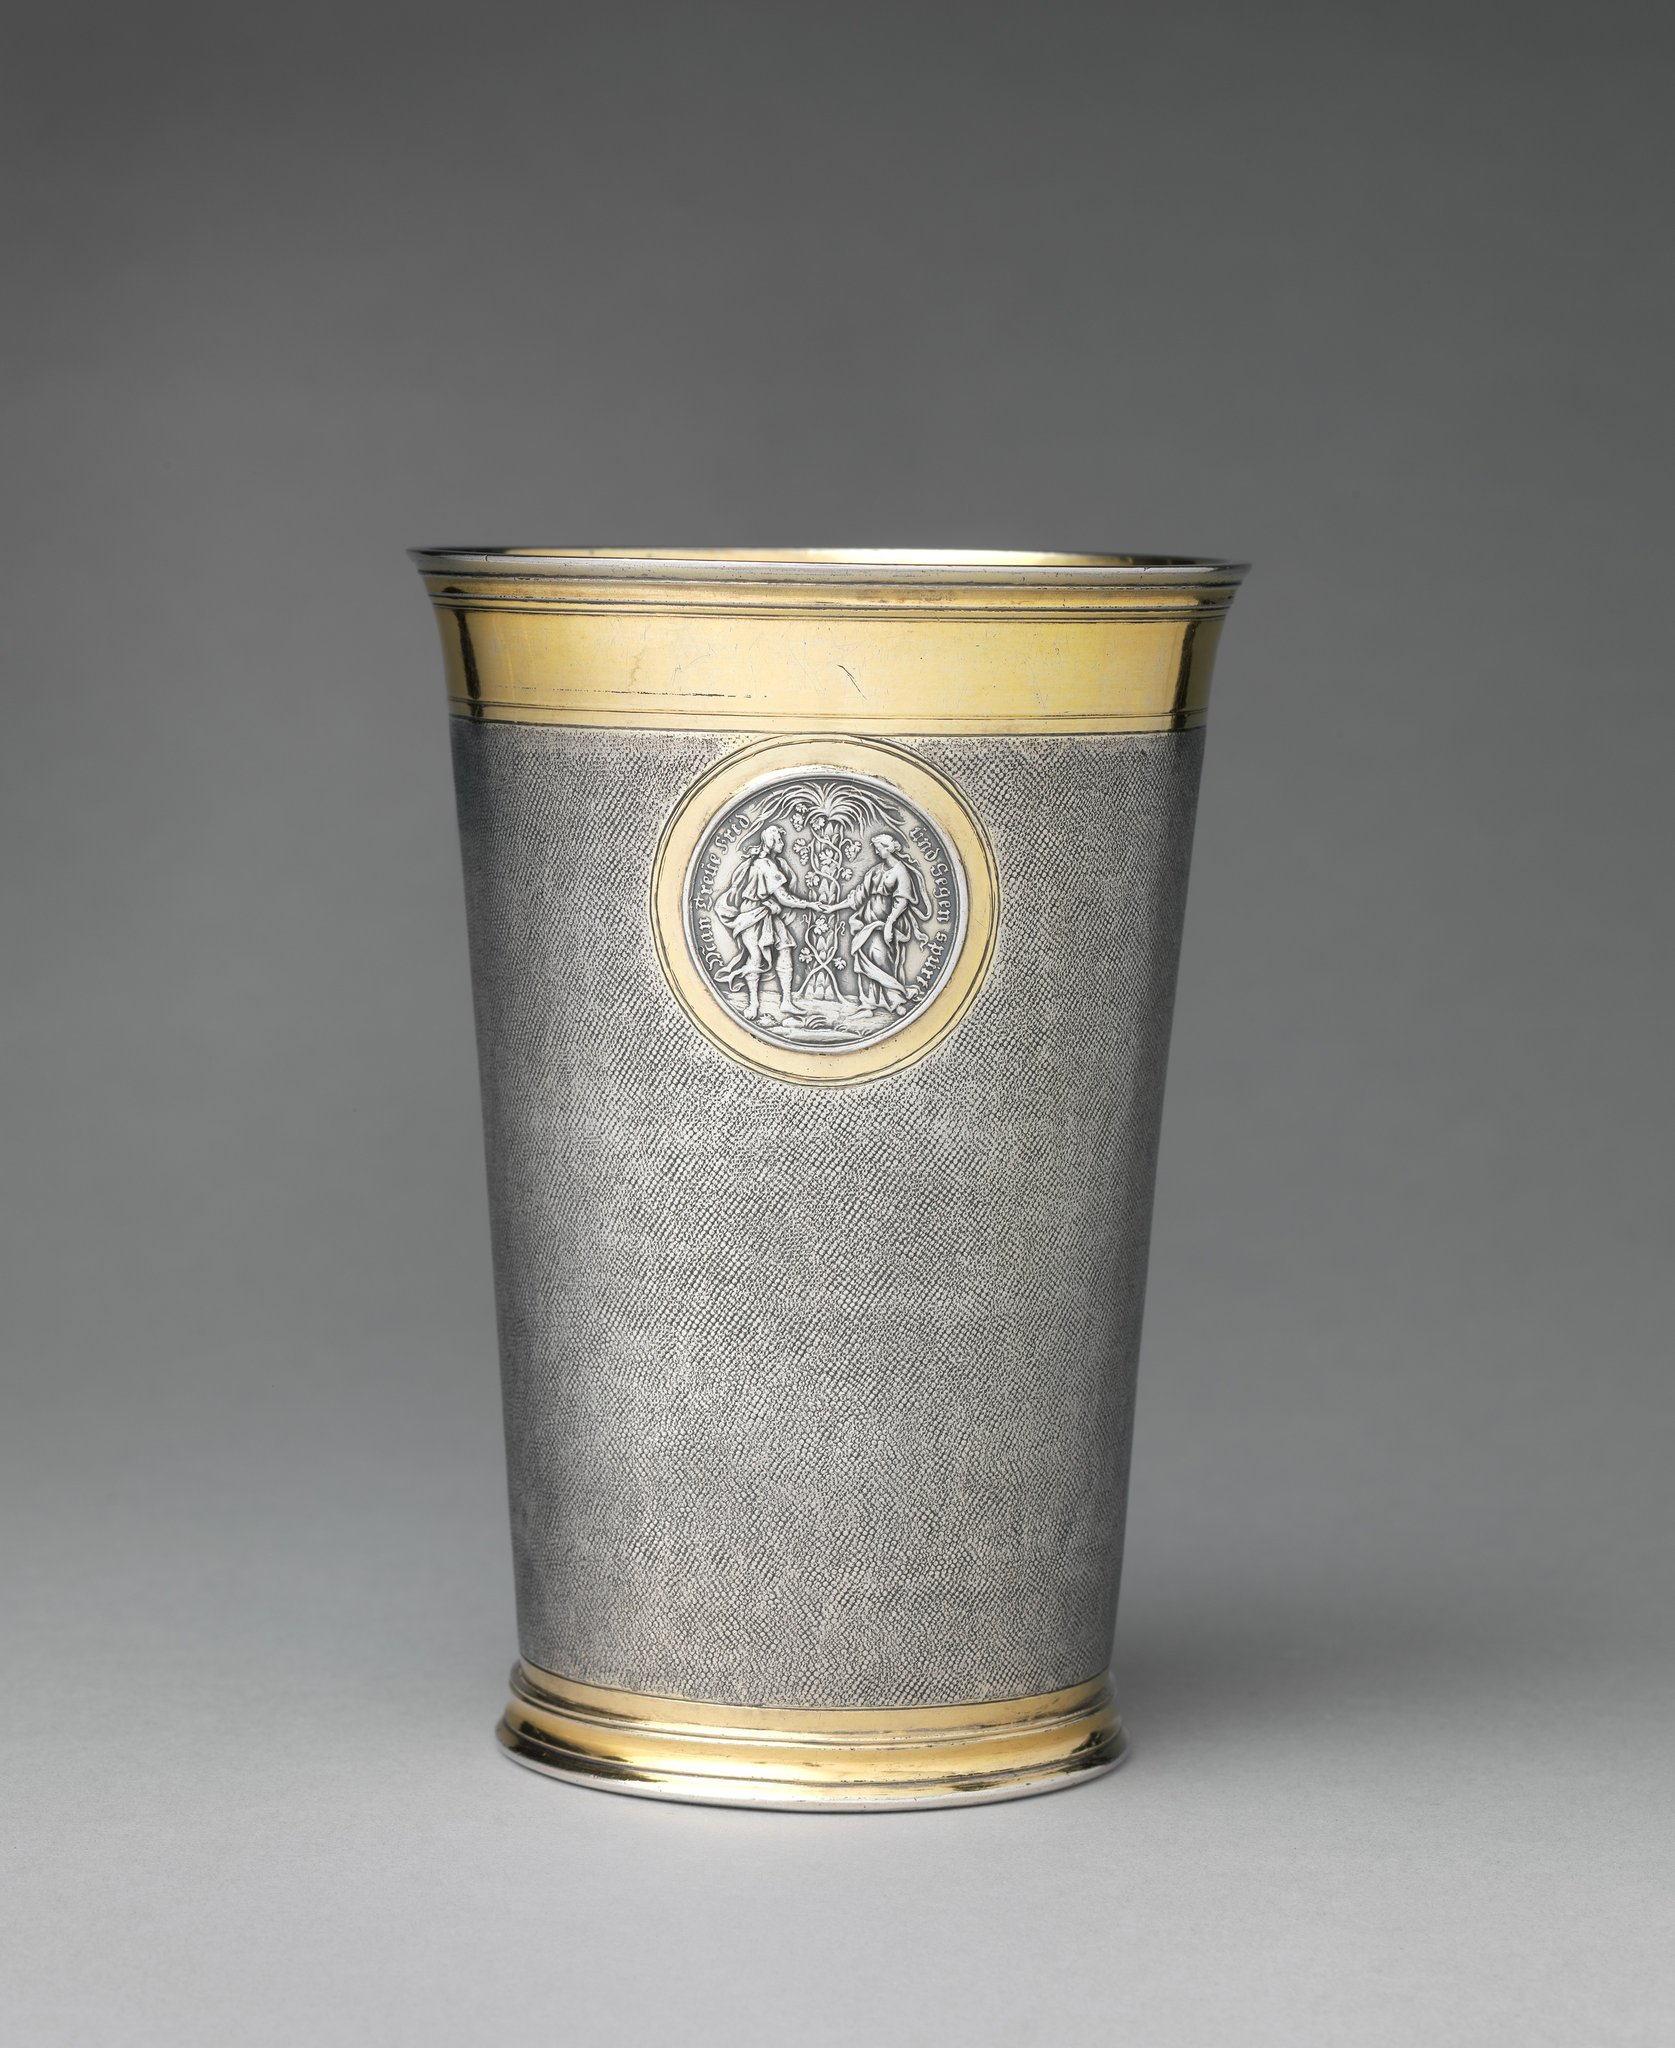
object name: beaker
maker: michael may ii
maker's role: maker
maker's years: 1731-1776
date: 1740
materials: silver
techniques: gilding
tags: human figures